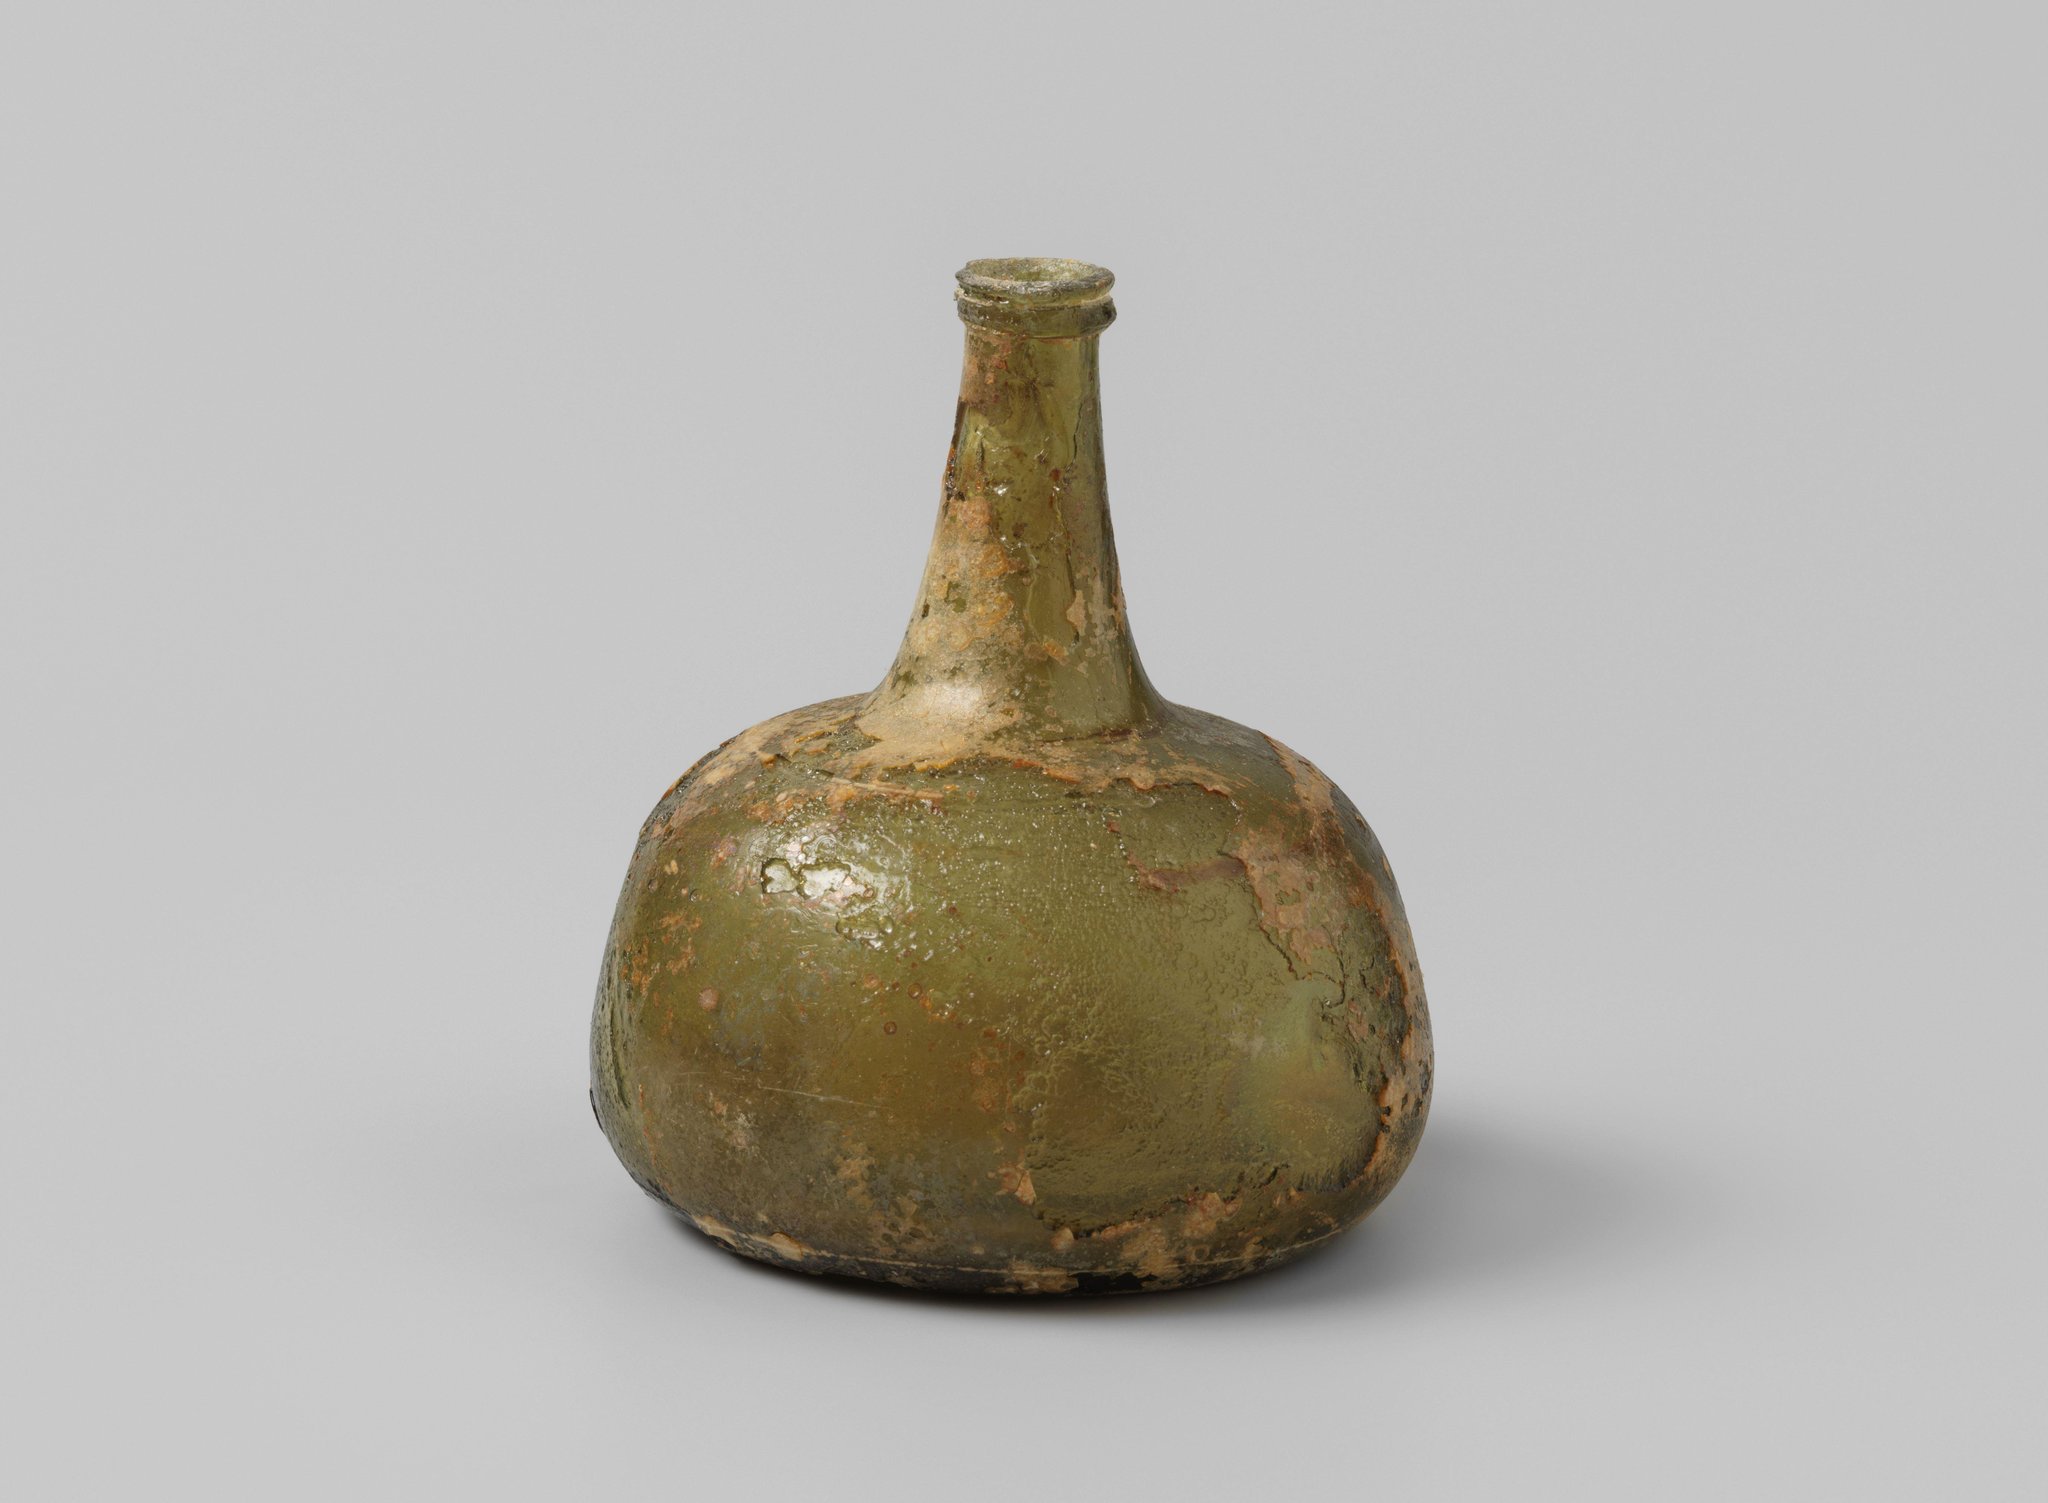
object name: wine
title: Wijnfles met wijn uit het wrak van de Oost-Indiëvaarder 't Vliegend Hart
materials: glass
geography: netherlands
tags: 't vliegend hart (schip), verenigde oostindische compagnie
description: Uivormige wijnfles van groen glas ooit gevuld met wijn. Kurk en draad die de kurk op de fles moest houden zijn verdwenen. De wijn is opgeslagen in een fles (NG-1984-86-1).